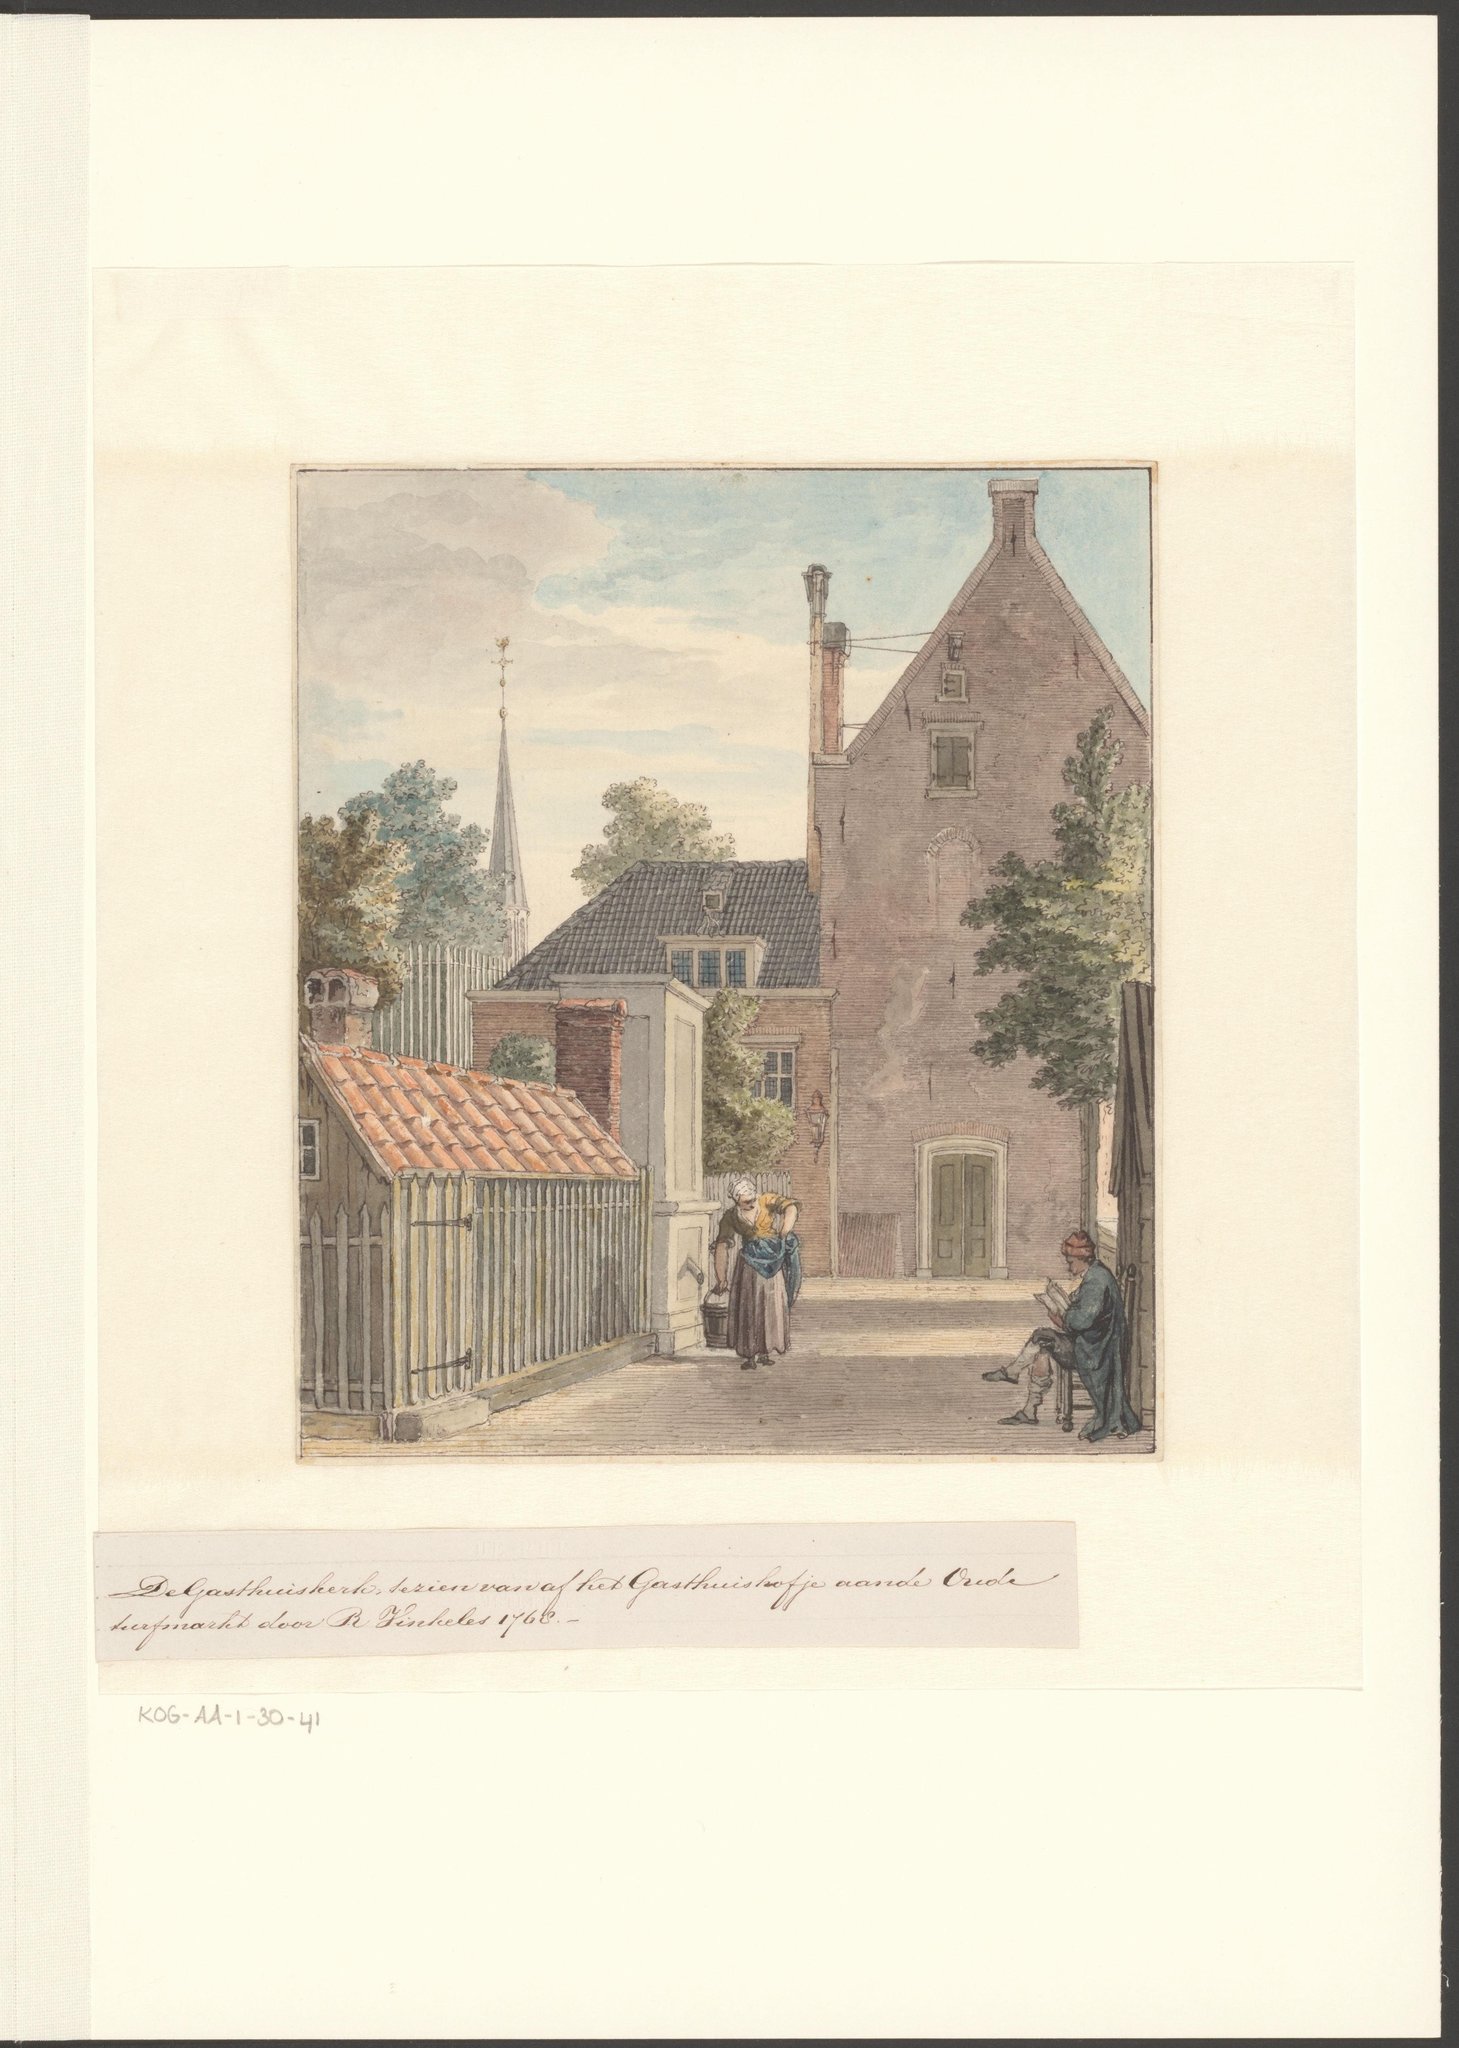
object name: drawing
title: Gezicht op de Gasthuiskerk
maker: reinier vinkeles (i)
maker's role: draughtsman, print maker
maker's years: 1741-1816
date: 1768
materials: ink, paper, pencil, watercolor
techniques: brush, pen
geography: amsterdam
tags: alms-house (dutch: 'hofje'), city-view in general; 'veduta', church (exterior)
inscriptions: inscription: ‘30.41A’, signature, date and inscription: ‘de gasthuijs kerk van het gasthuijs hofje te zien. 1768. / RVinkeles delin 1768.’, inscription: ‘De Gasthuiskerk, te (...) R. Vinkeles 1768.-’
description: Onderwerpsrubriek binnen de Atlas Amsterdam: Gasthuiskerk.